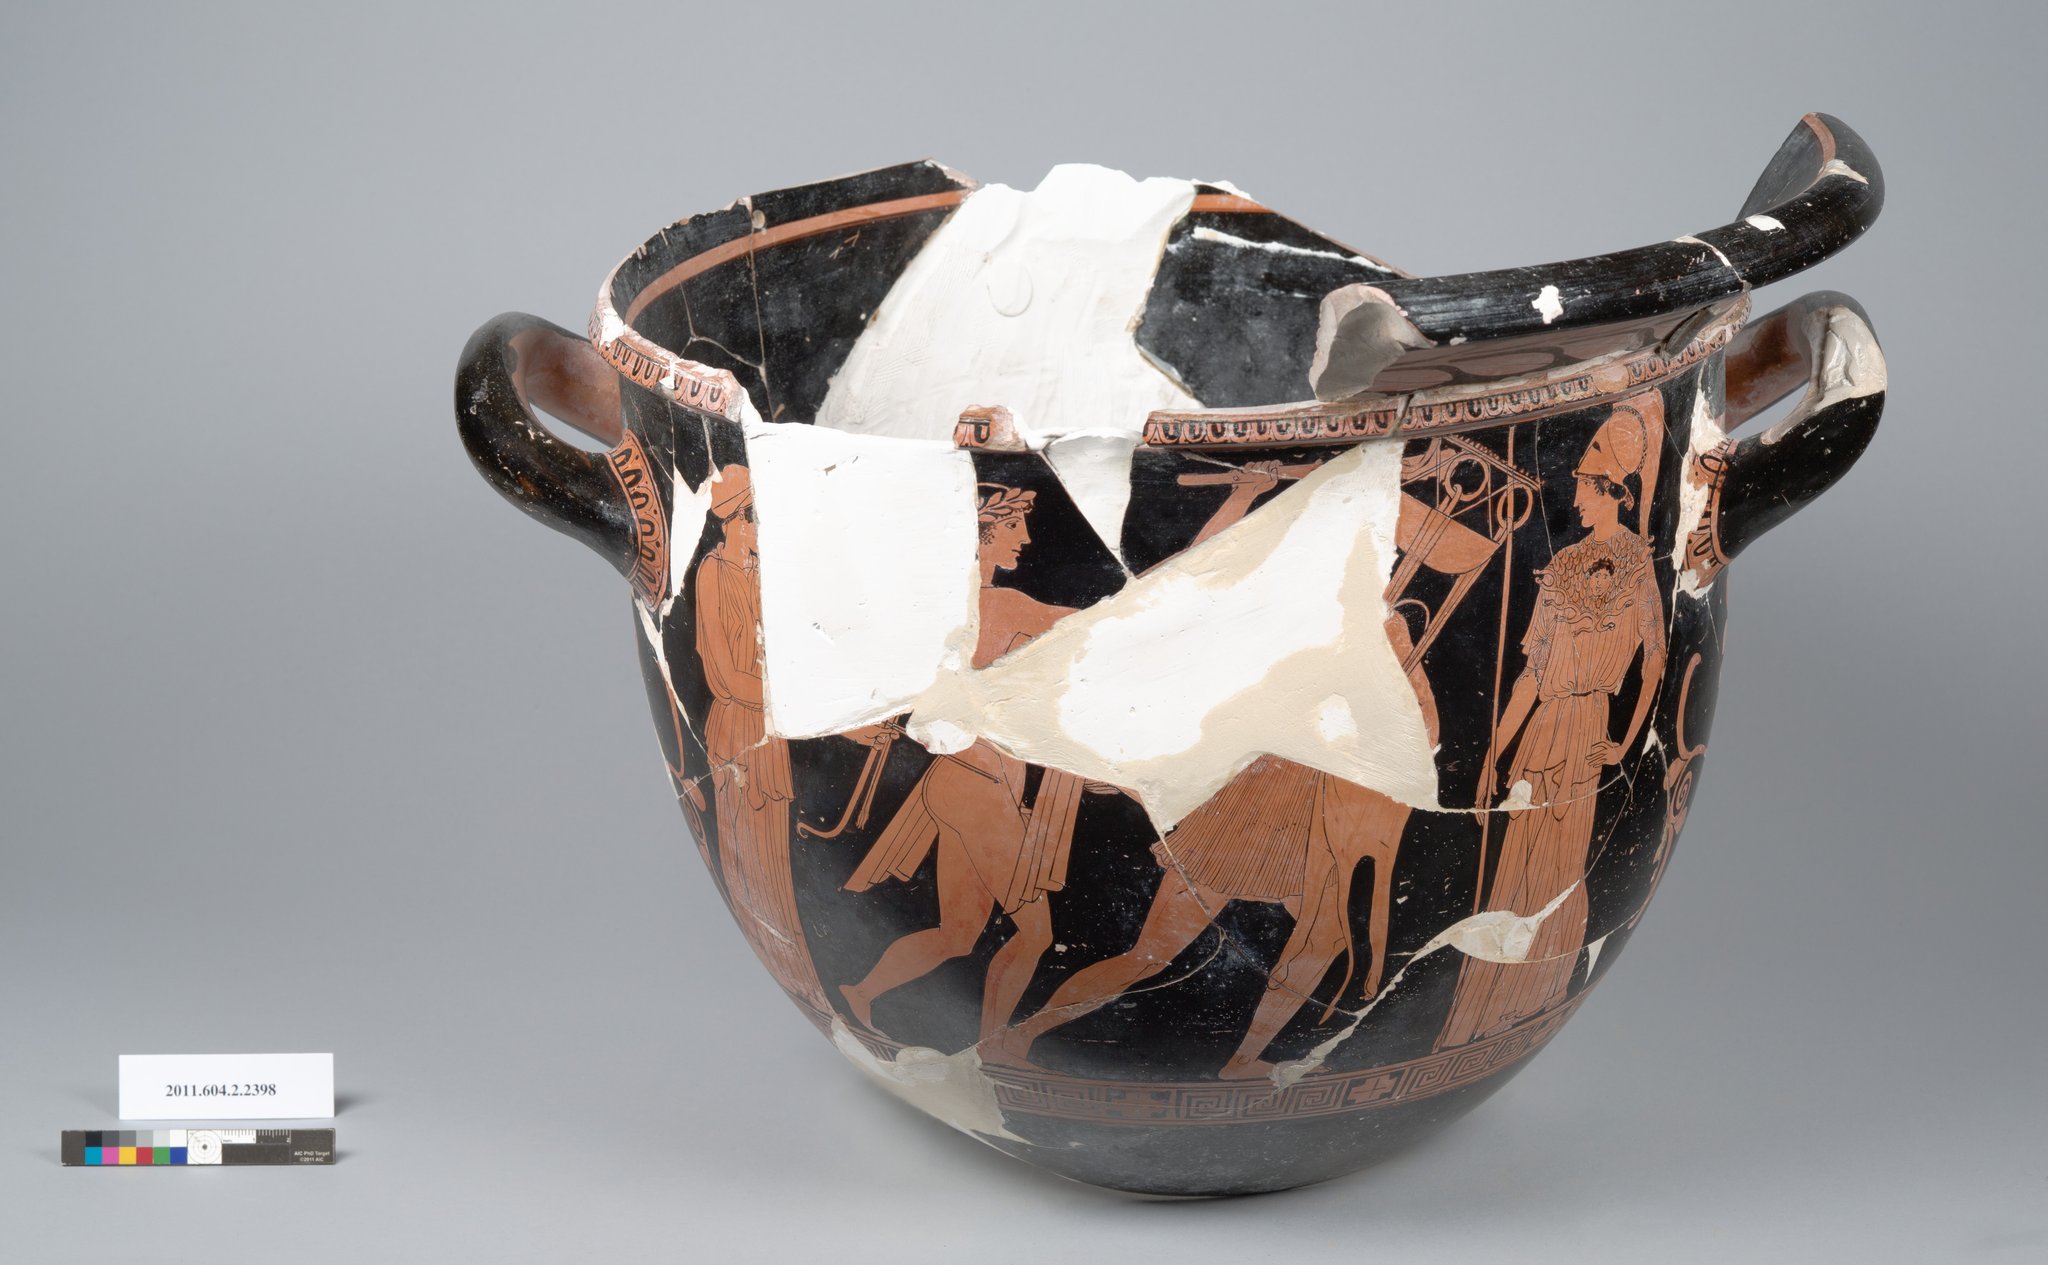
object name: bell krater fragment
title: Terracotta fragment of a bell-krater (bowl for mixing wine and water)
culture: greek, attic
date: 460-440 BCE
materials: terracotta